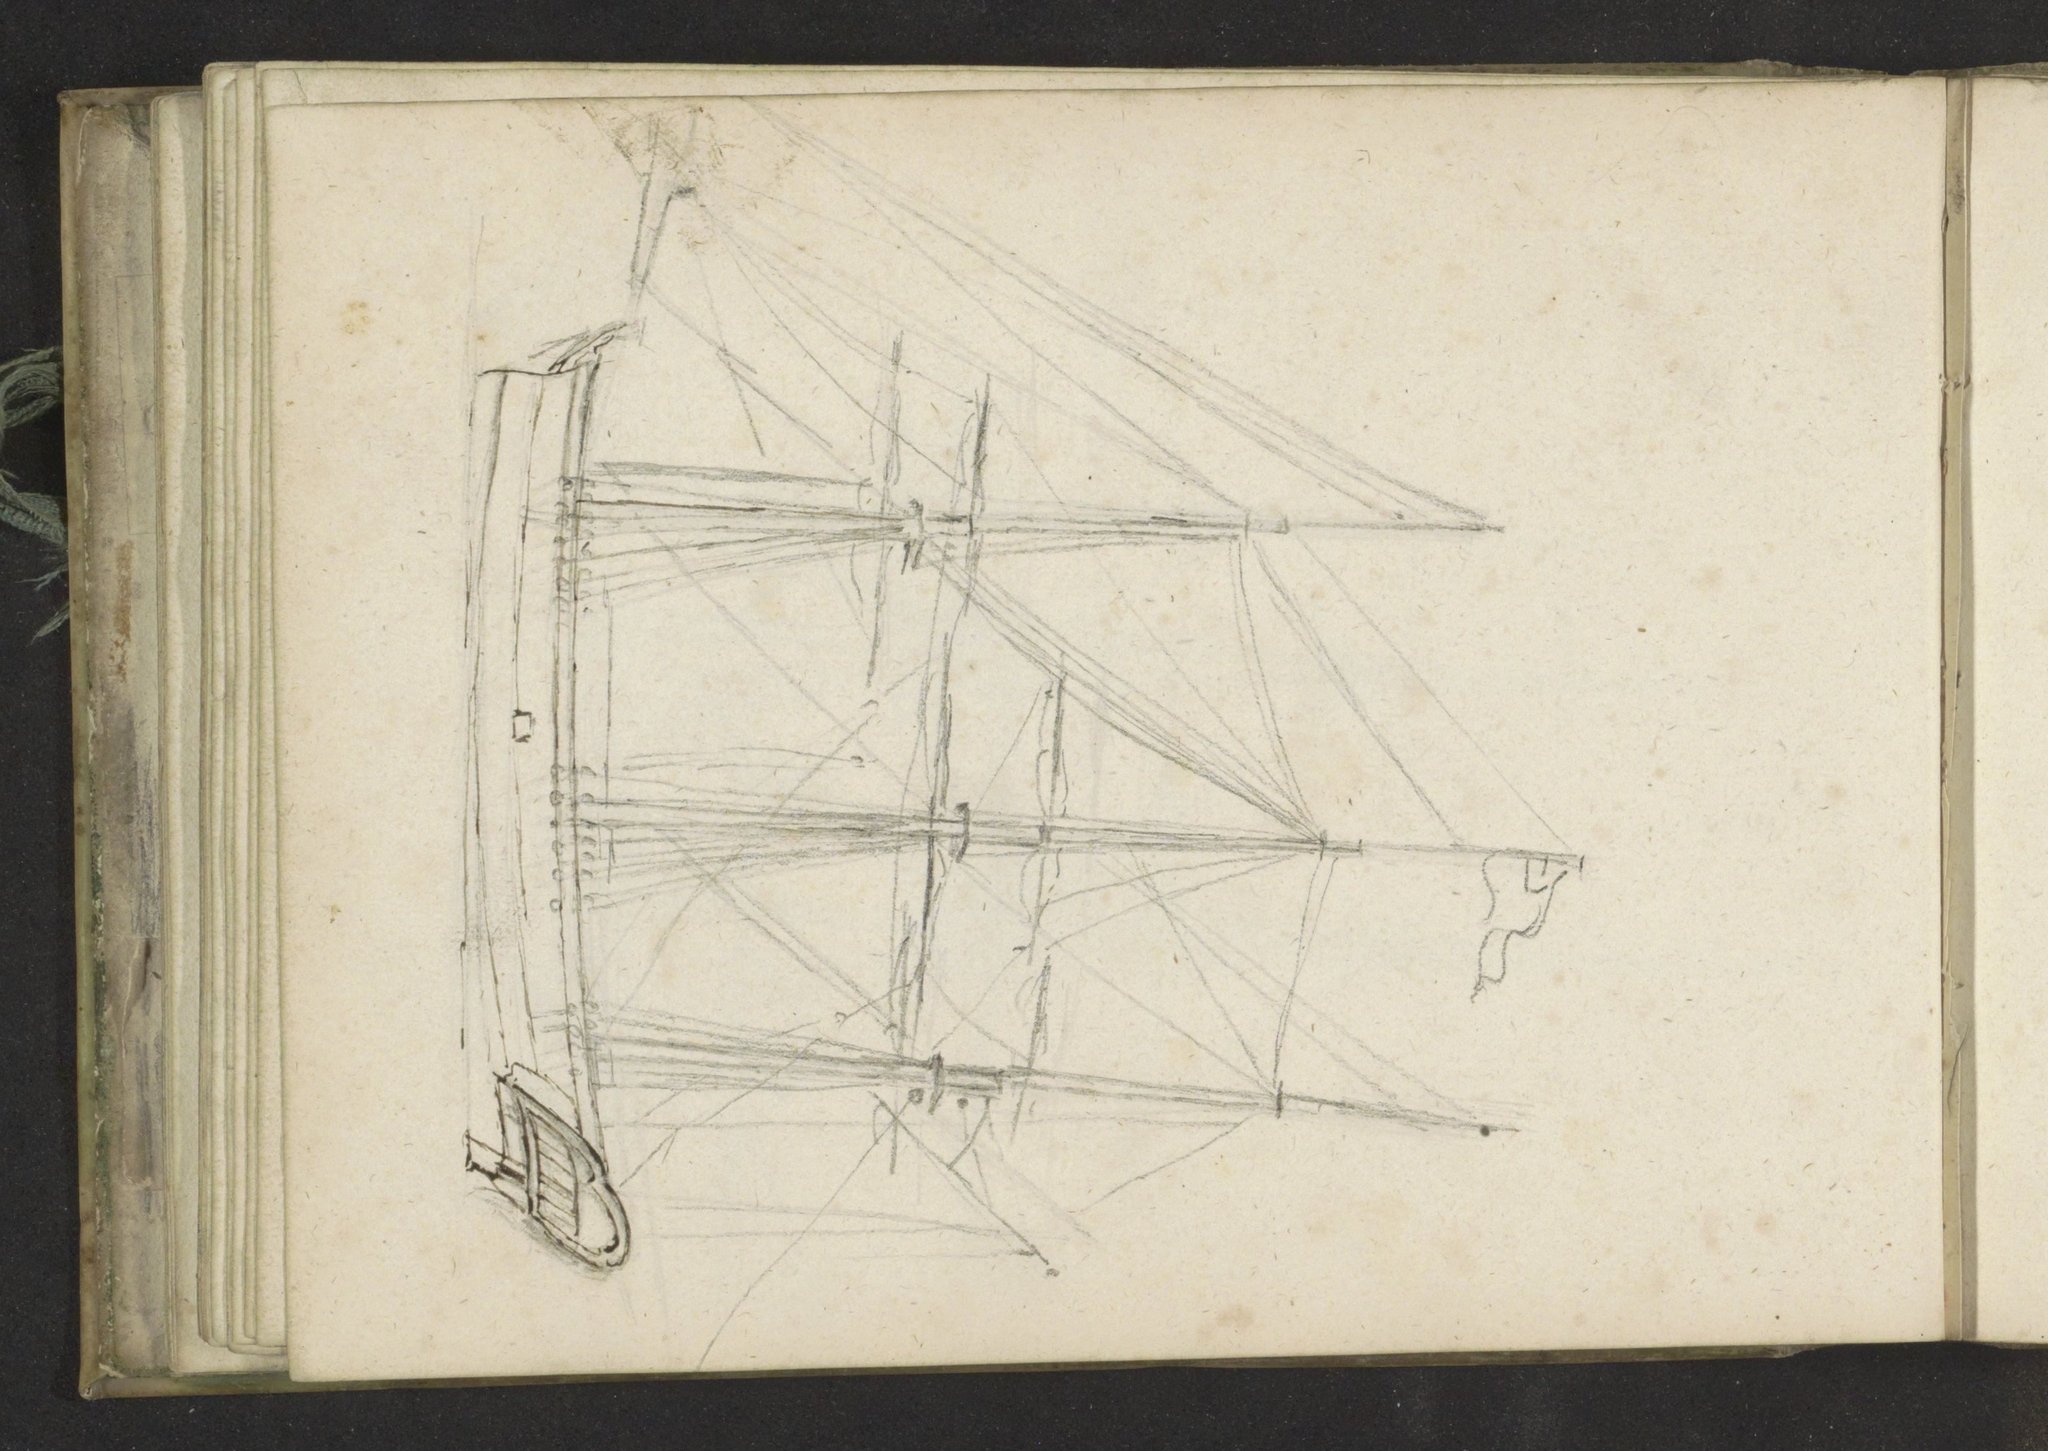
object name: sketchbook leaf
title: Driemaster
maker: martinus schouman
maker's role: draughtsman, painter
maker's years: 1770-1848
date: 1780-1848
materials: ink, paper, pencil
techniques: pen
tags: sailing-ship, sailing-boat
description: Blad 26 verso uit een schetsboek met 53 bladen.